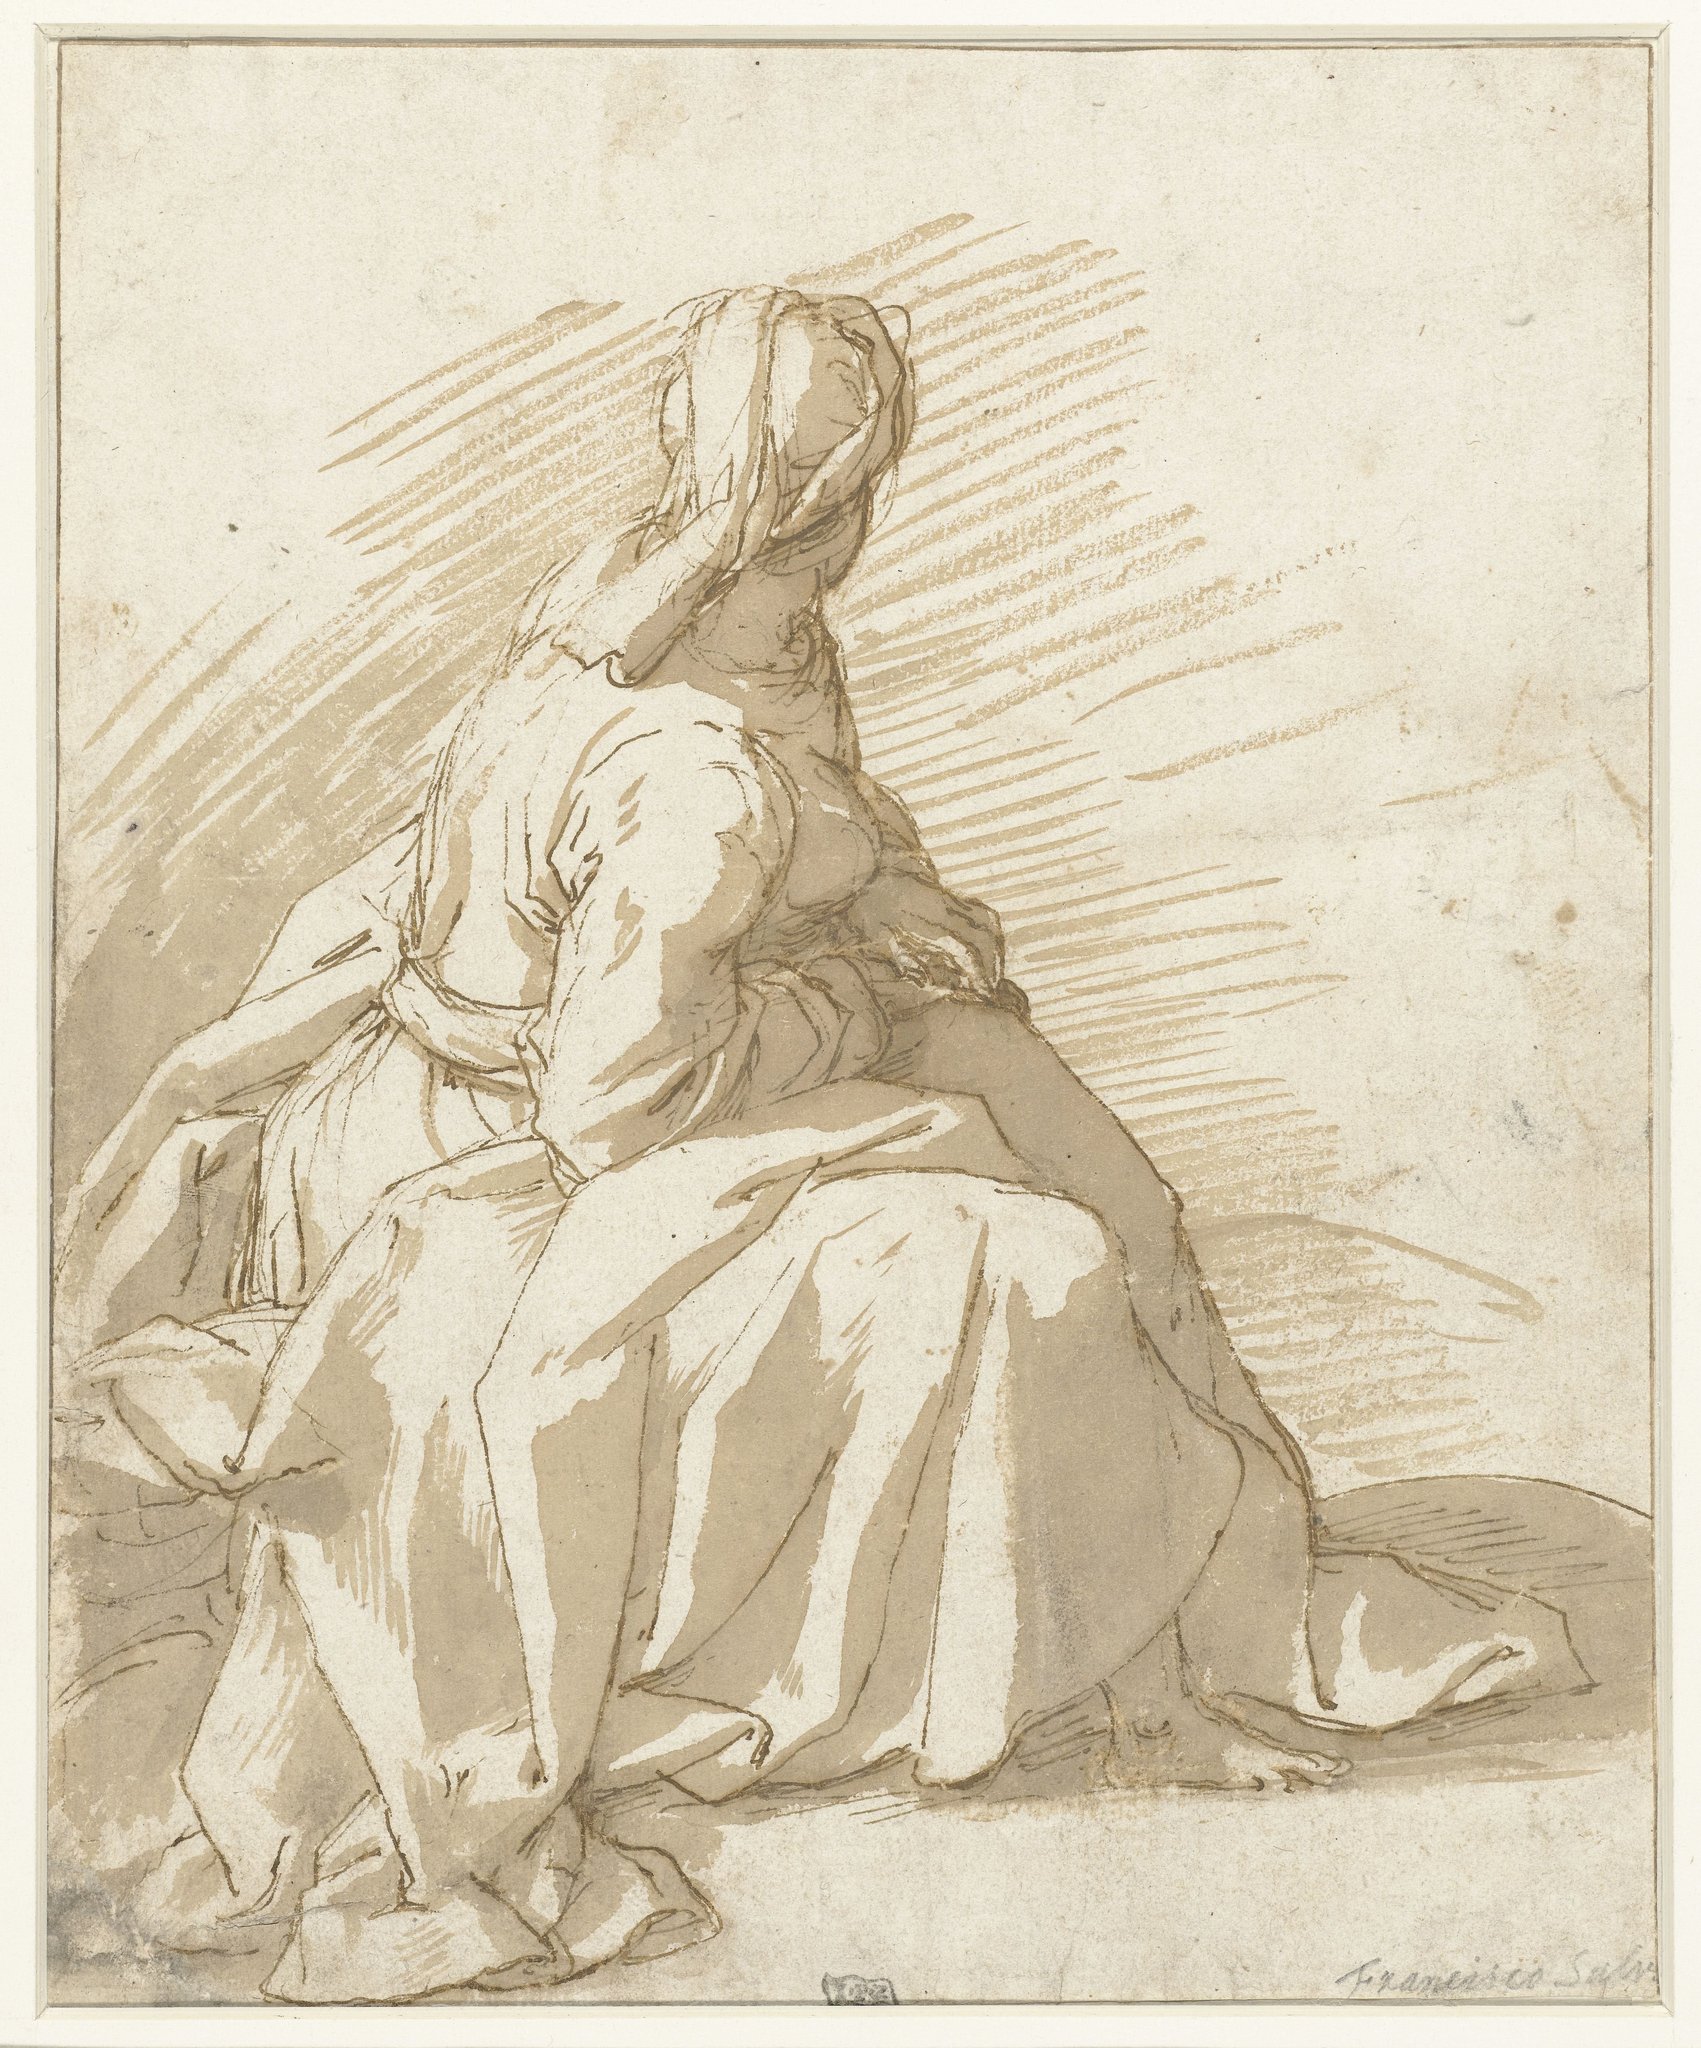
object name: drawing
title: Zittende vrouw, naar rechts gewend en achterom kijkend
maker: giovanni antonio da pesaro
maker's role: draughtsman, painter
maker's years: 1415-1478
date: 1560-1600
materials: ink, paper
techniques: brush, pen